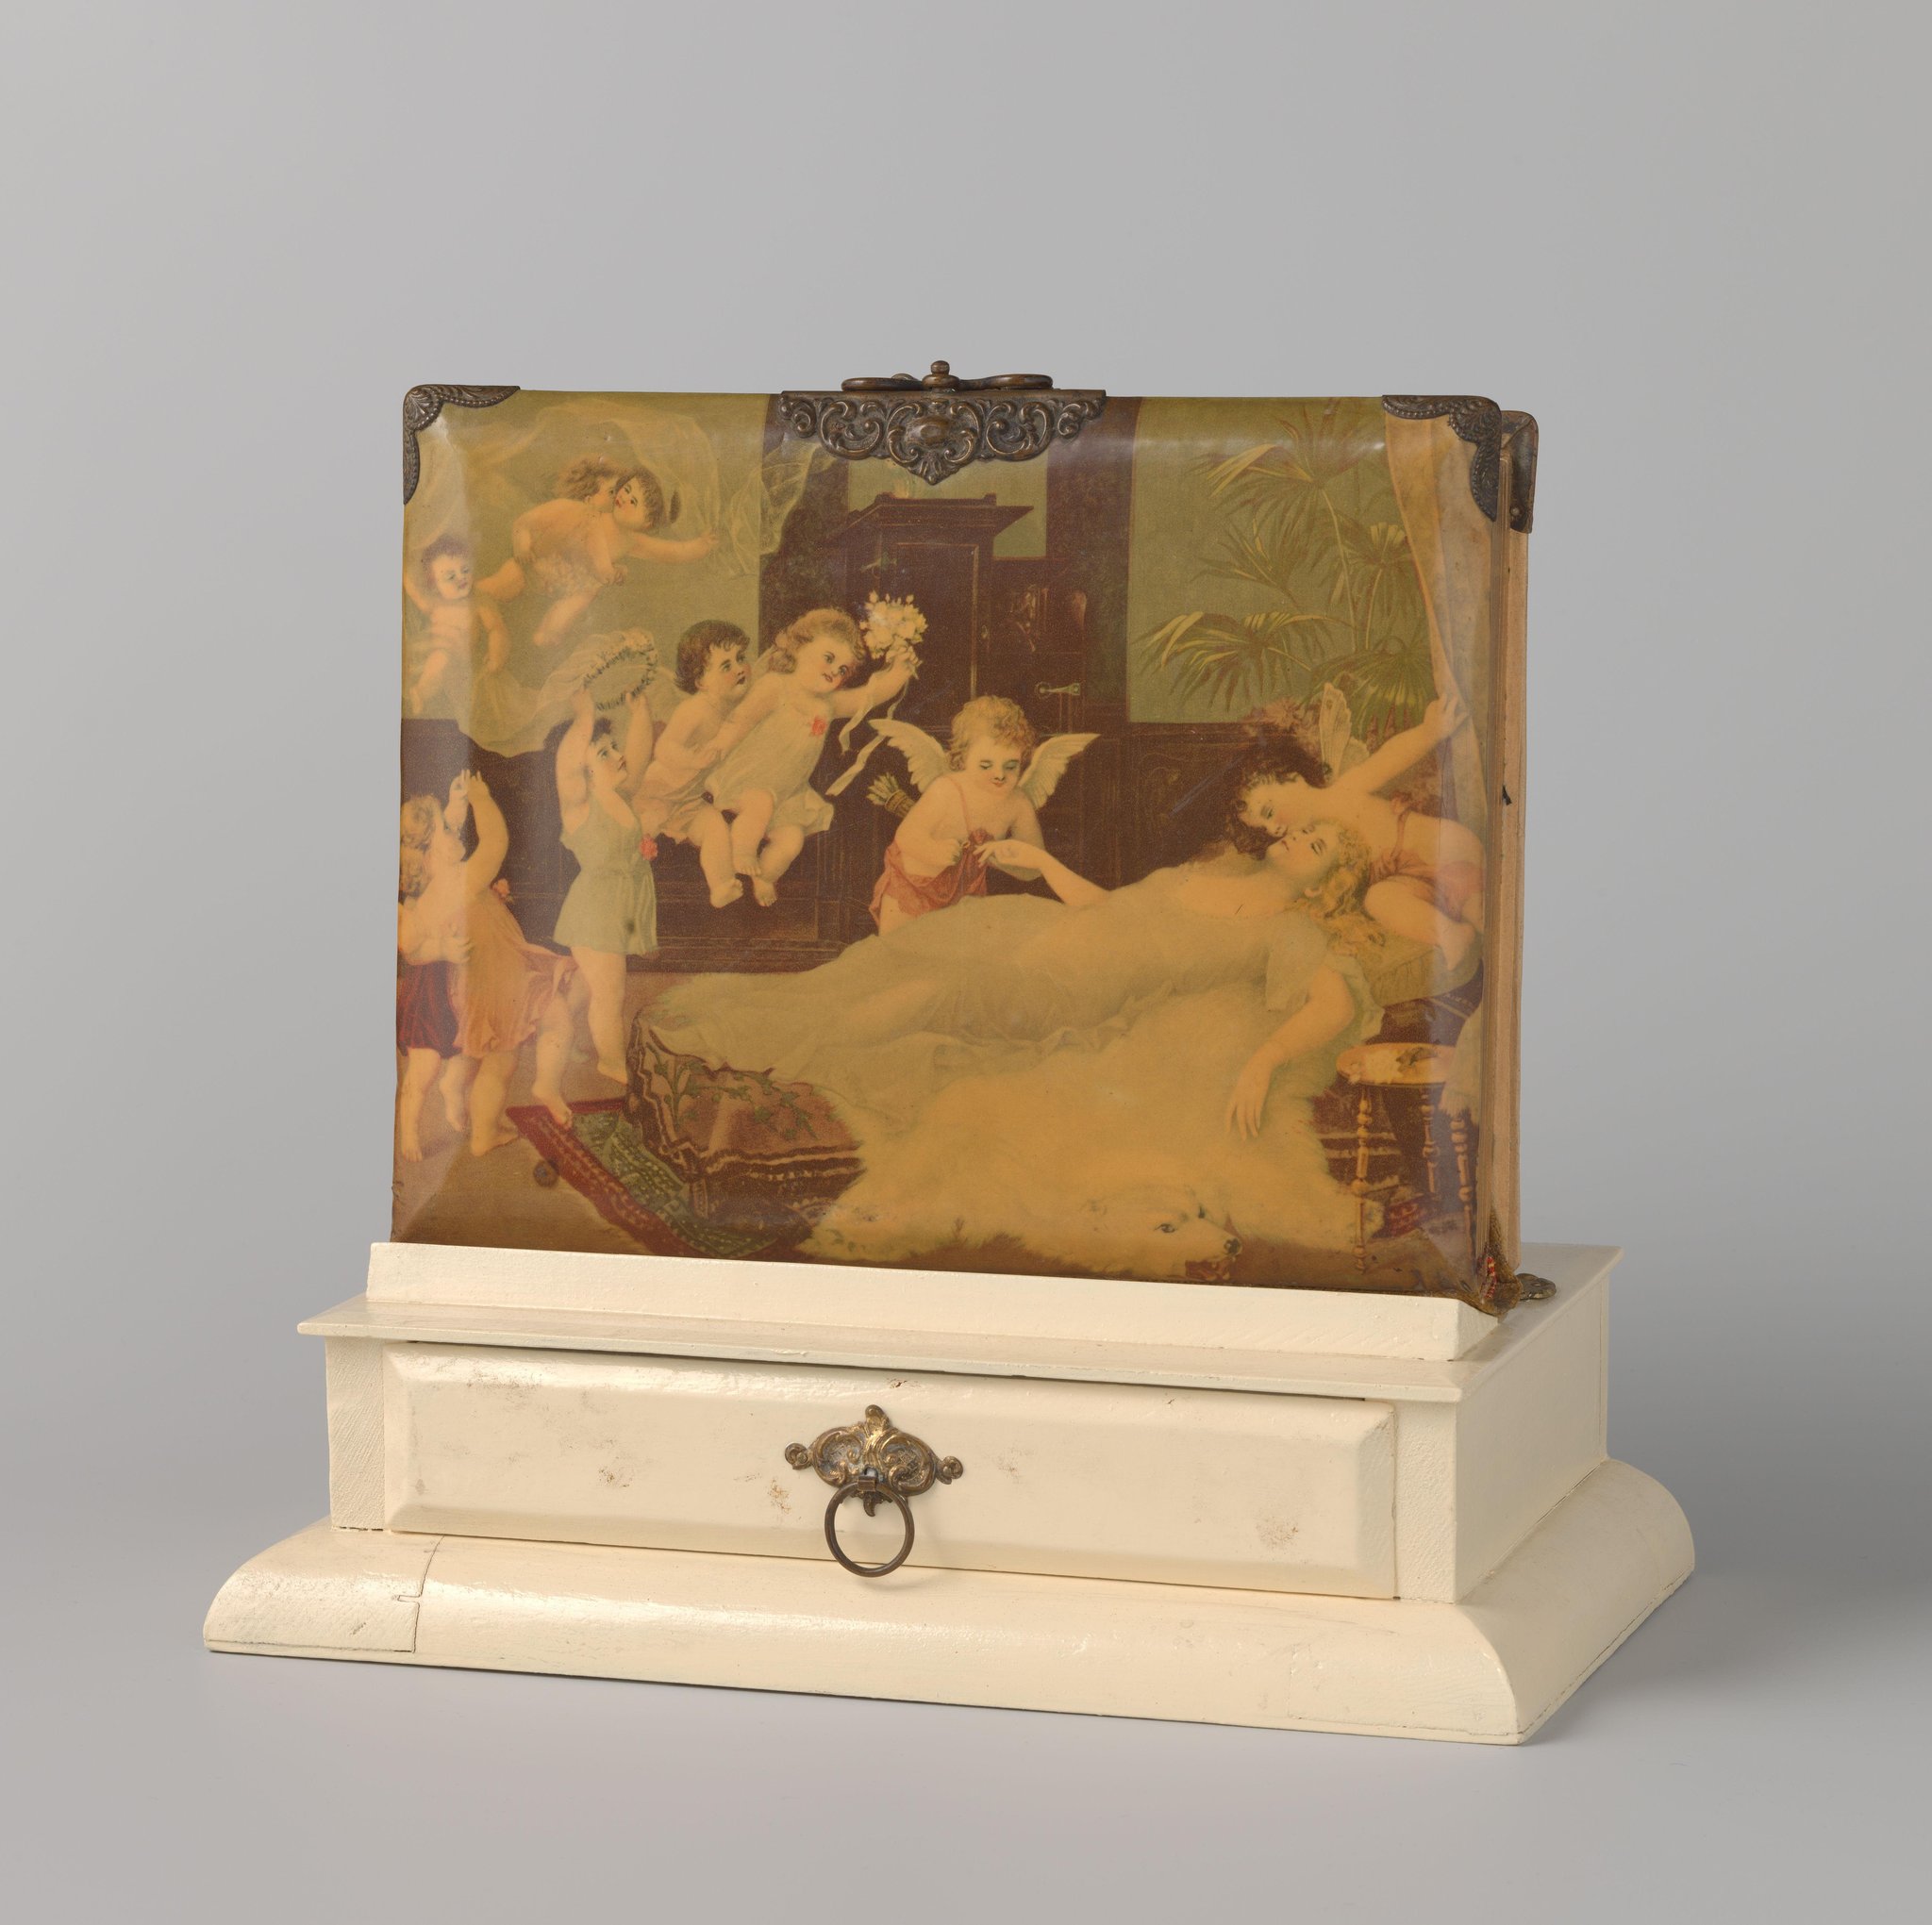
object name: slip in album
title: Duits familiealbum met 36 foto's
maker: Anonymous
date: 1860-1900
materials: cardboard, metal, paper, photographic support, velvet, wood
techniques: albumen print, decorated paper, gelatin silver print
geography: germany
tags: adolescent, young woman, maiden, historical persons - bb - woman, child, historical persons, youth, adolescent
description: Fotoalbum met in totaal 36 foto's op 28 pagina's. Het album bevat 8 kabinetfoto's en 28 cartes-de-visite in met gouden lijnen omkaderde passe-partouts. Afgebeeld zijn portretten van onbekende mannen, vrouwen en kinderen. De foto's zijn gemaakt door verschillende Duitse fotografen, waaronder Hans Rupprecht en August Reinhard Heinrich Brade. Van 8 foto's is de fotograaf anoniem.